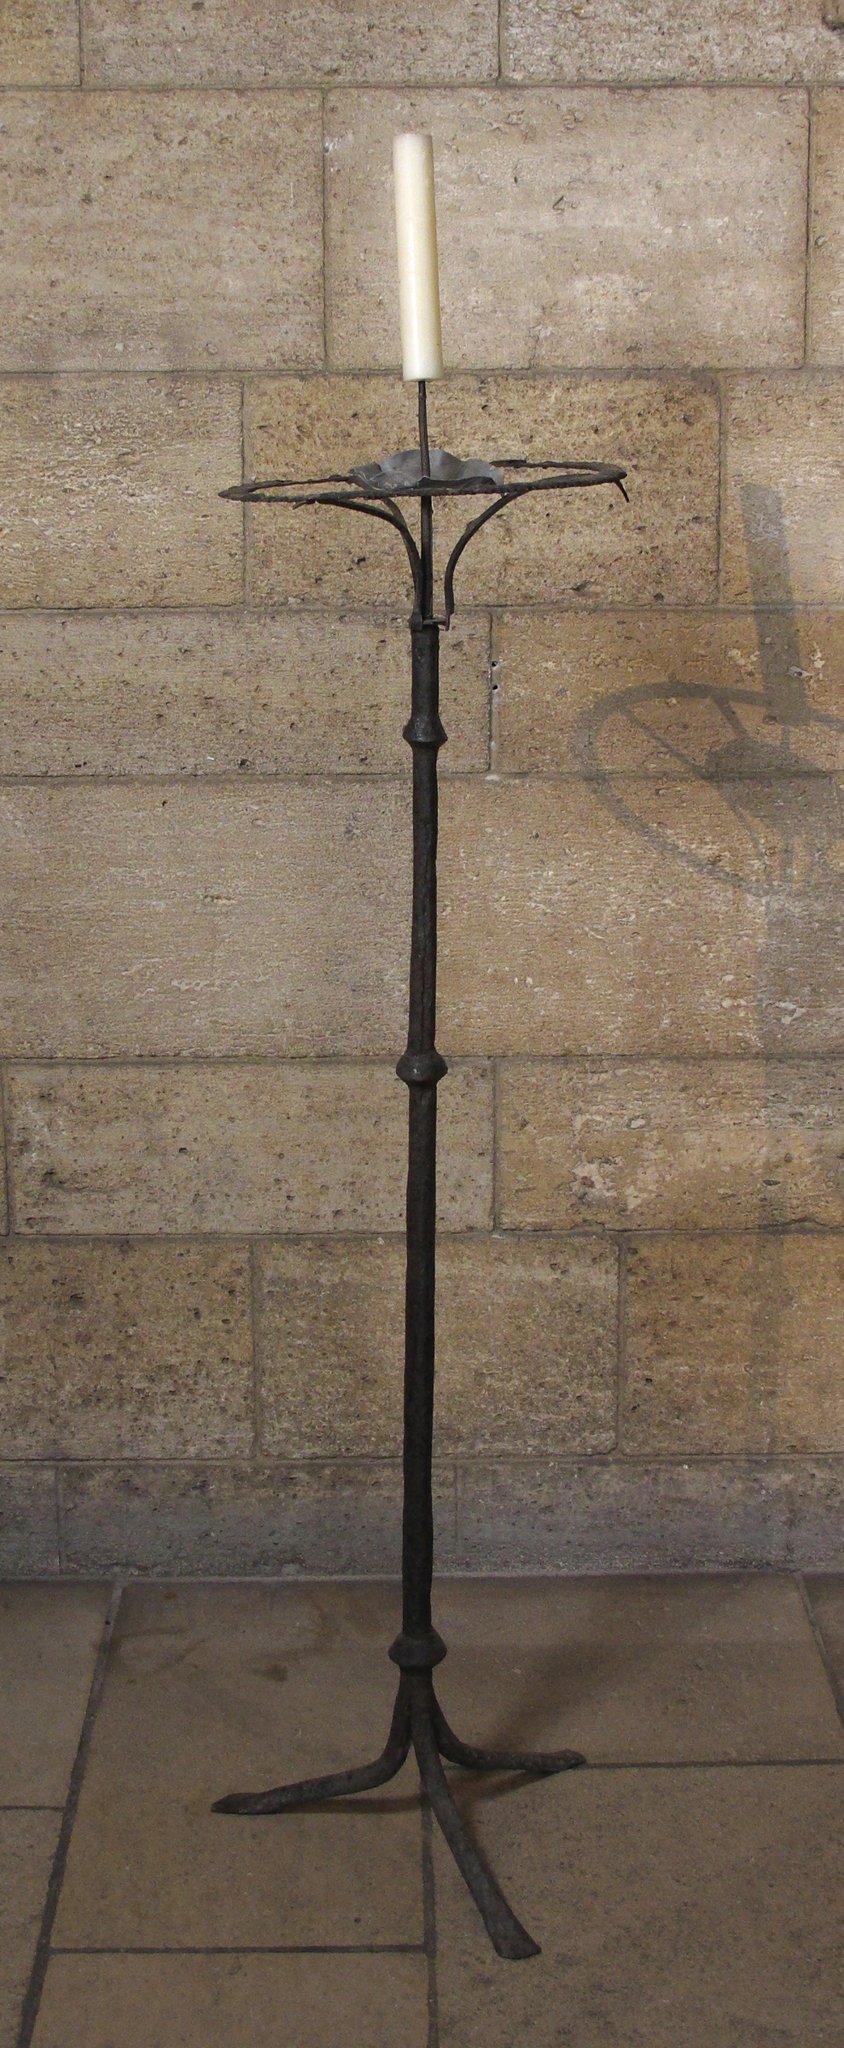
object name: candelabrum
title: Candelabra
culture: spanish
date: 1501-1600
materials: iron